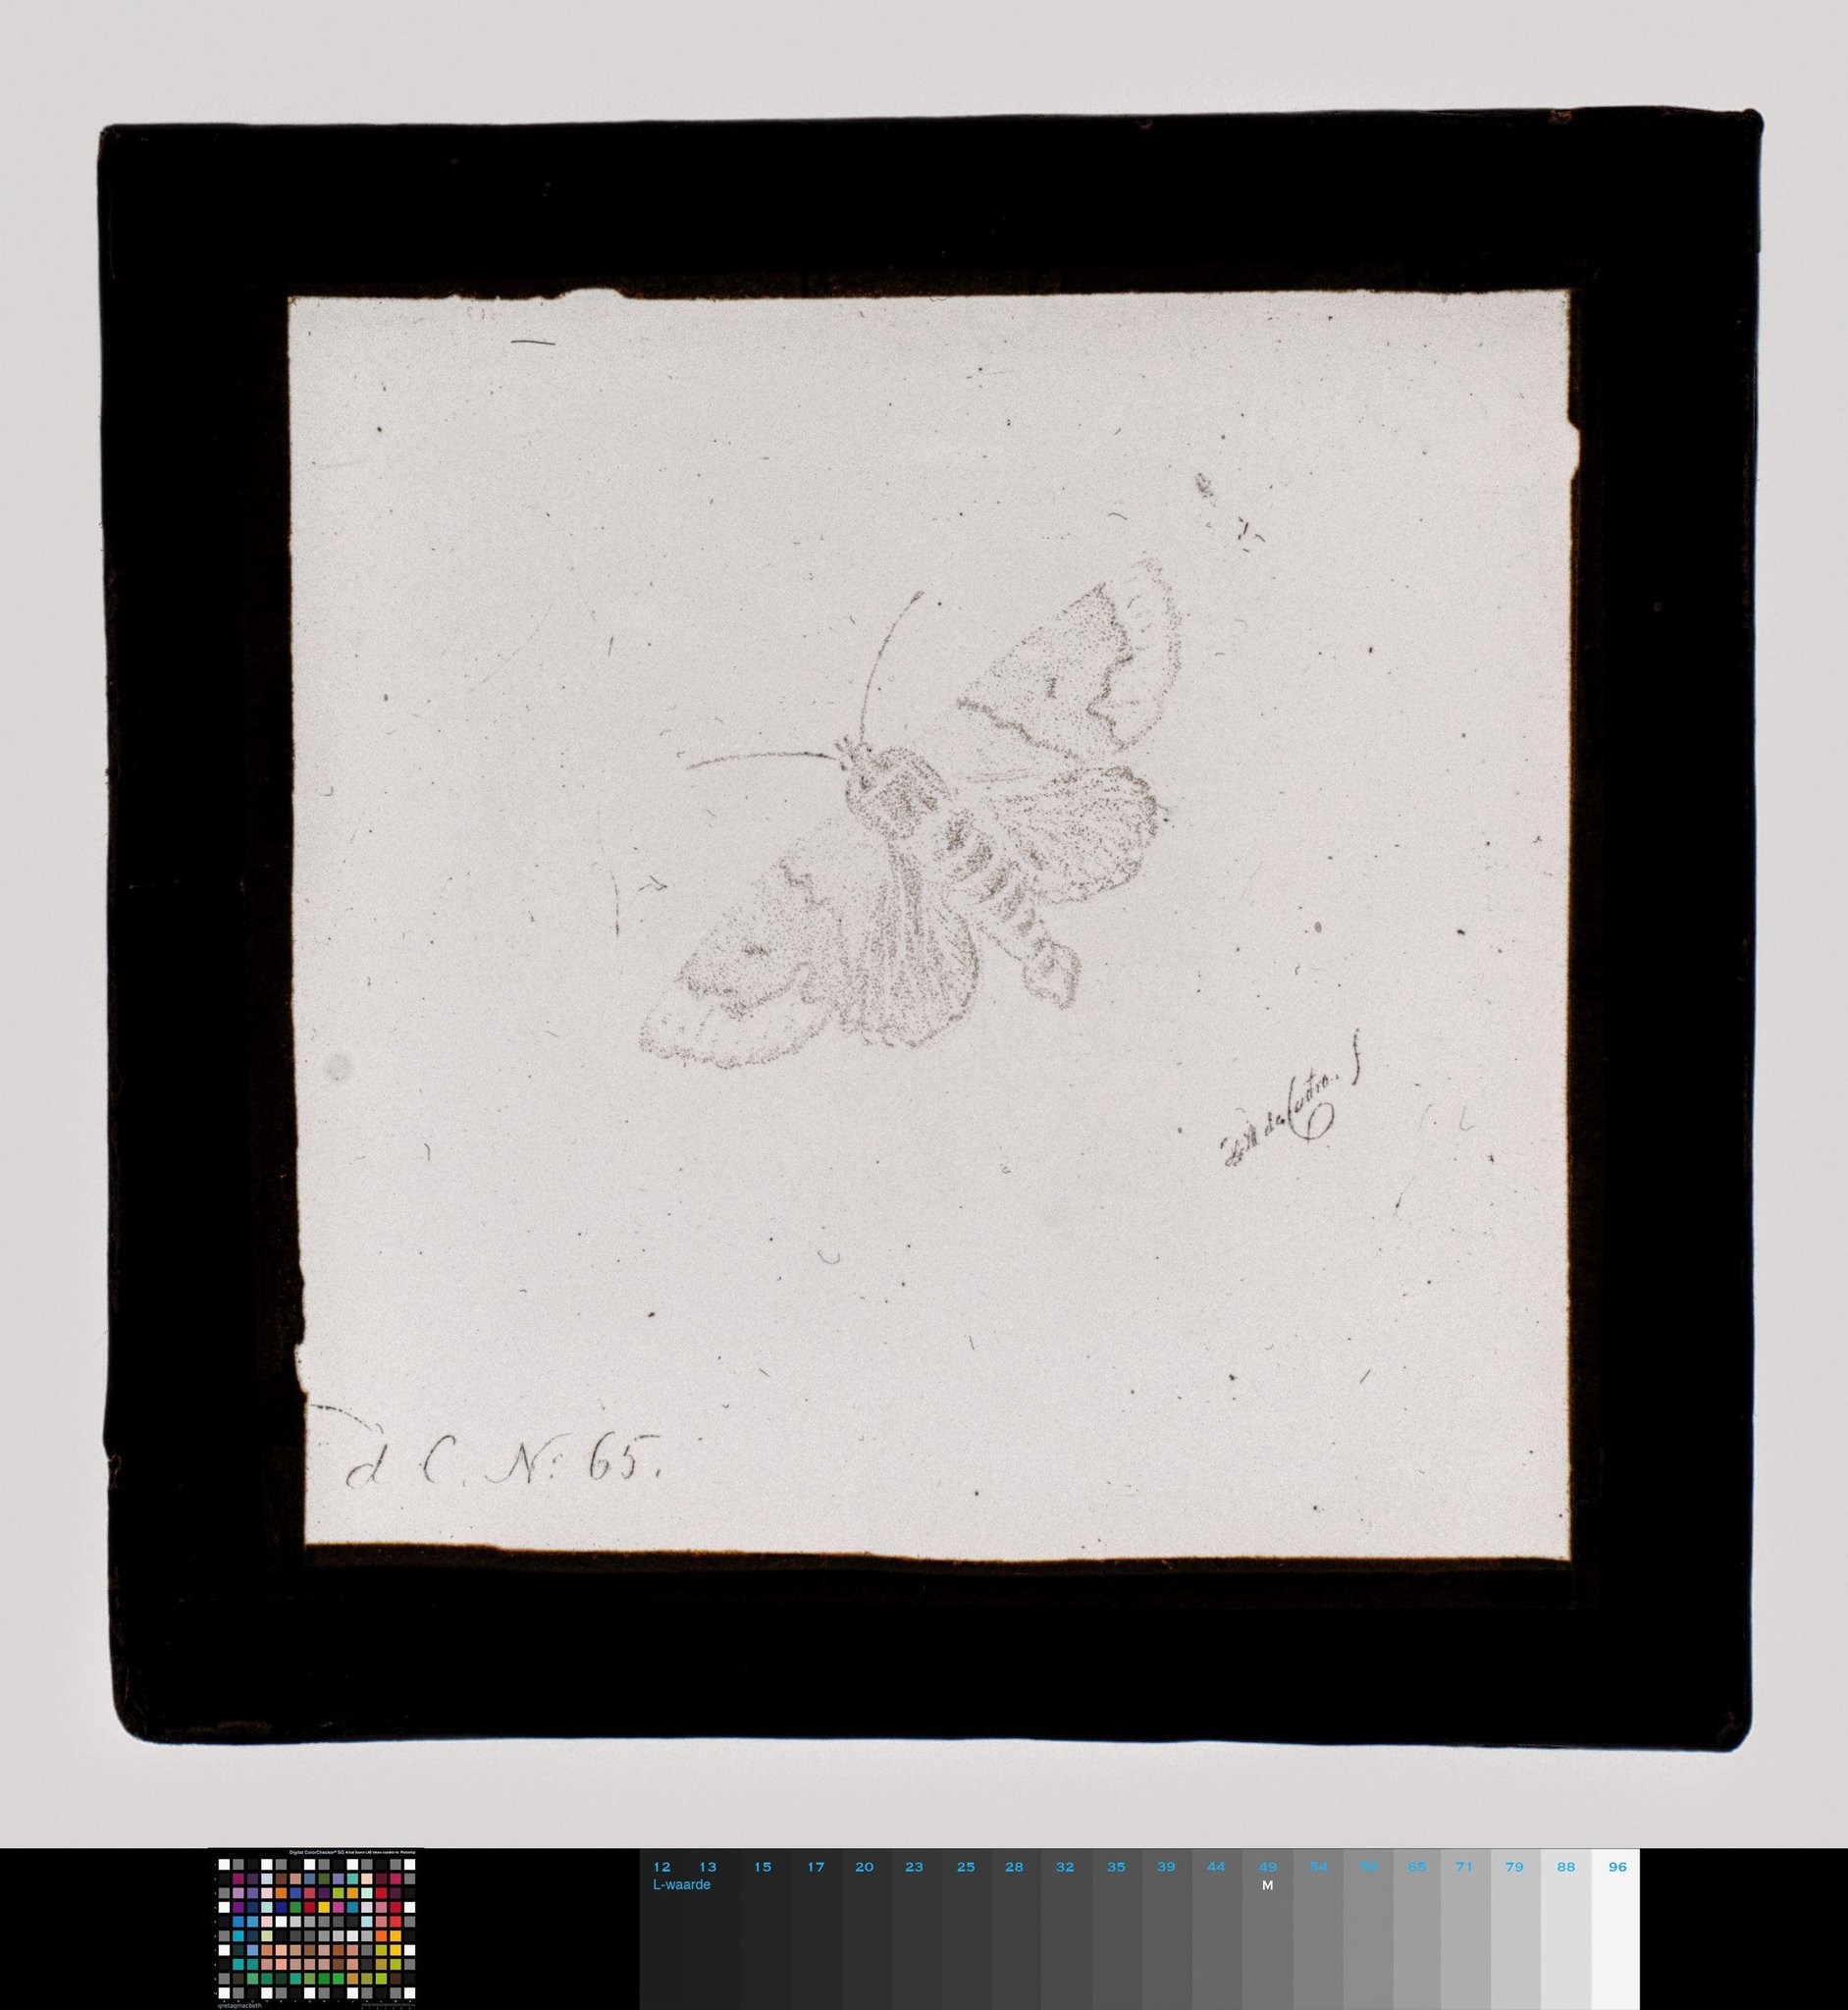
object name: light window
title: Ruit met vlinder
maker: daniël henriques de castro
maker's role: glasgraveur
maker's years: 1806-1863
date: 1850-1863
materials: glass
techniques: diamond point engraving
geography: amsterdam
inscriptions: signature: ‘D.H. de Castro. f.’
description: Ruit, vierkant, met in het midden een vlinder. Ingelijst met zwart papier met een vergulde lijst.